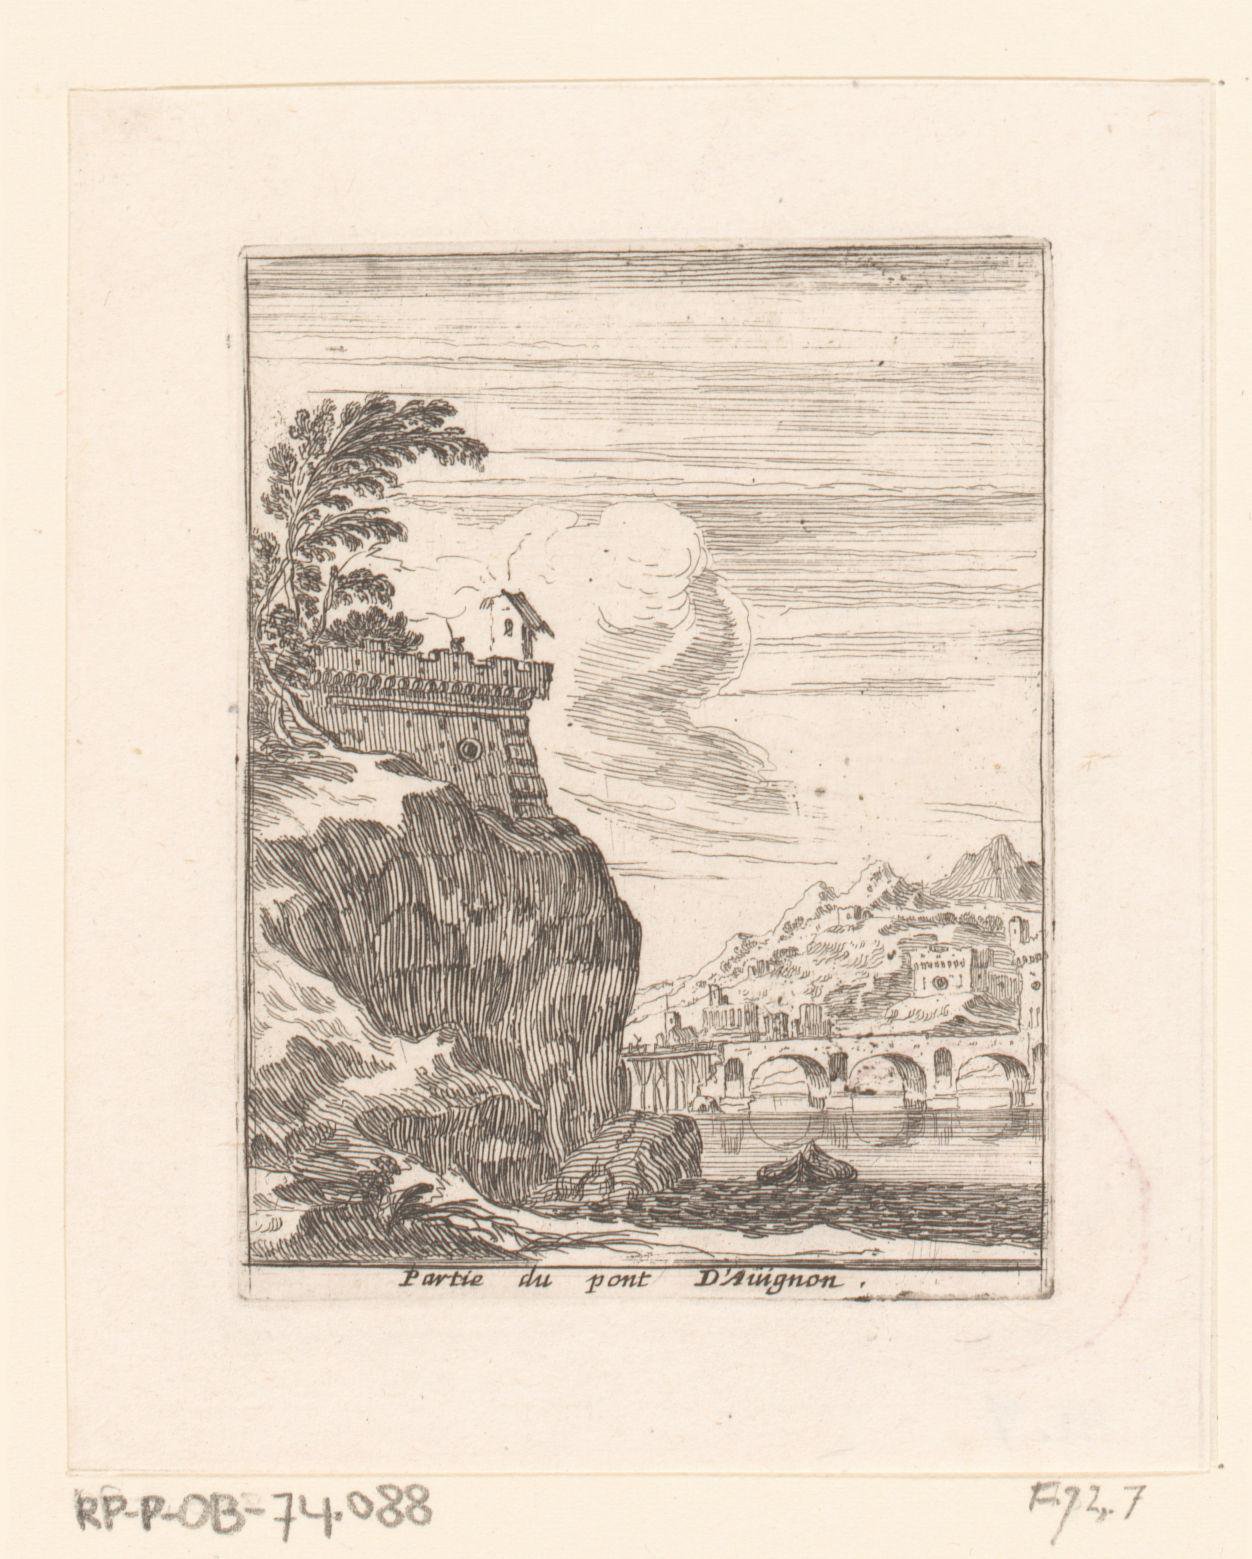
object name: print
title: Diverse gezichten door Israël Silvestre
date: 1631-1661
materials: paper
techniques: etching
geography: france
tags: landscape with bridge, viaduct or aqueduct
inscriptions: collector's mark: Lugt 240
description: Prent maakt deel uit van een ongenummerde serie van negen prenten.